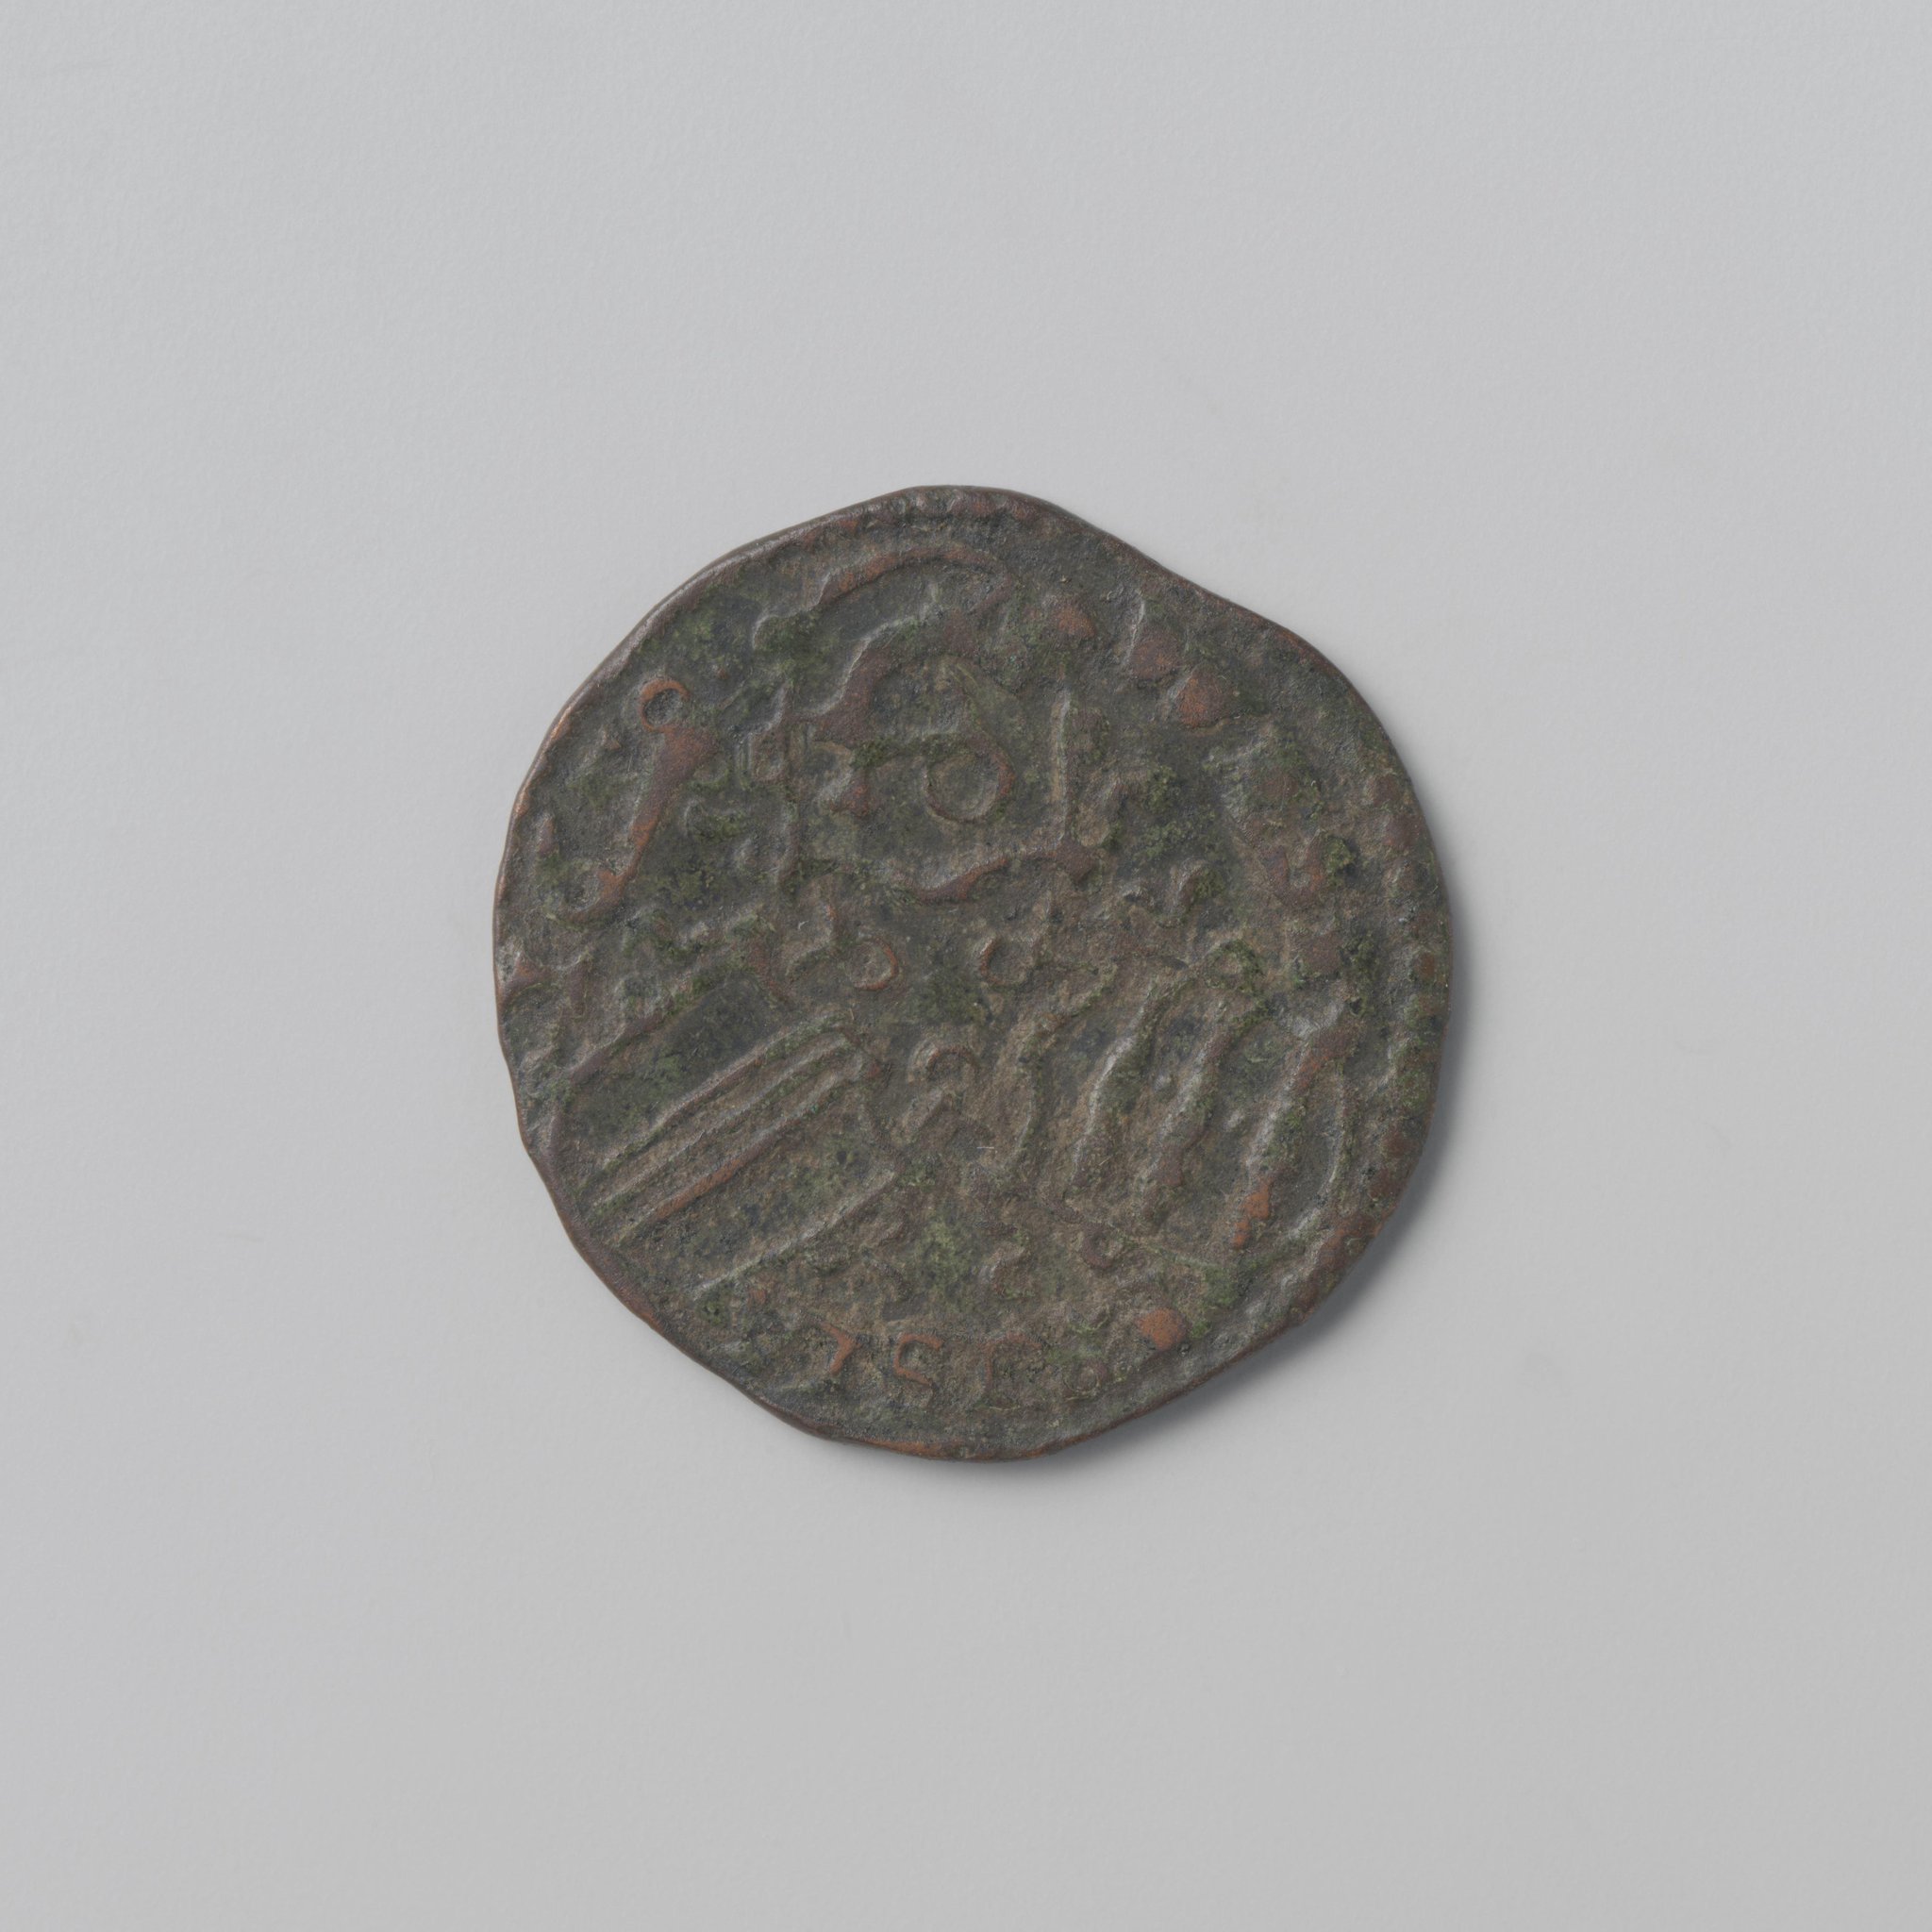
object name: coin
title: Westfriese duit, 1658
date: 1658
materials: copper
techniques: striking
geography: west frisia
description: Koperen munt. Voorzijde: gekroond en versierd wapenschild van West-Friesland. Keerzijde: drie versierde, aan bovenkant gebogen wapenschilden van Enkhuizen, Hoorn en Medemblik.